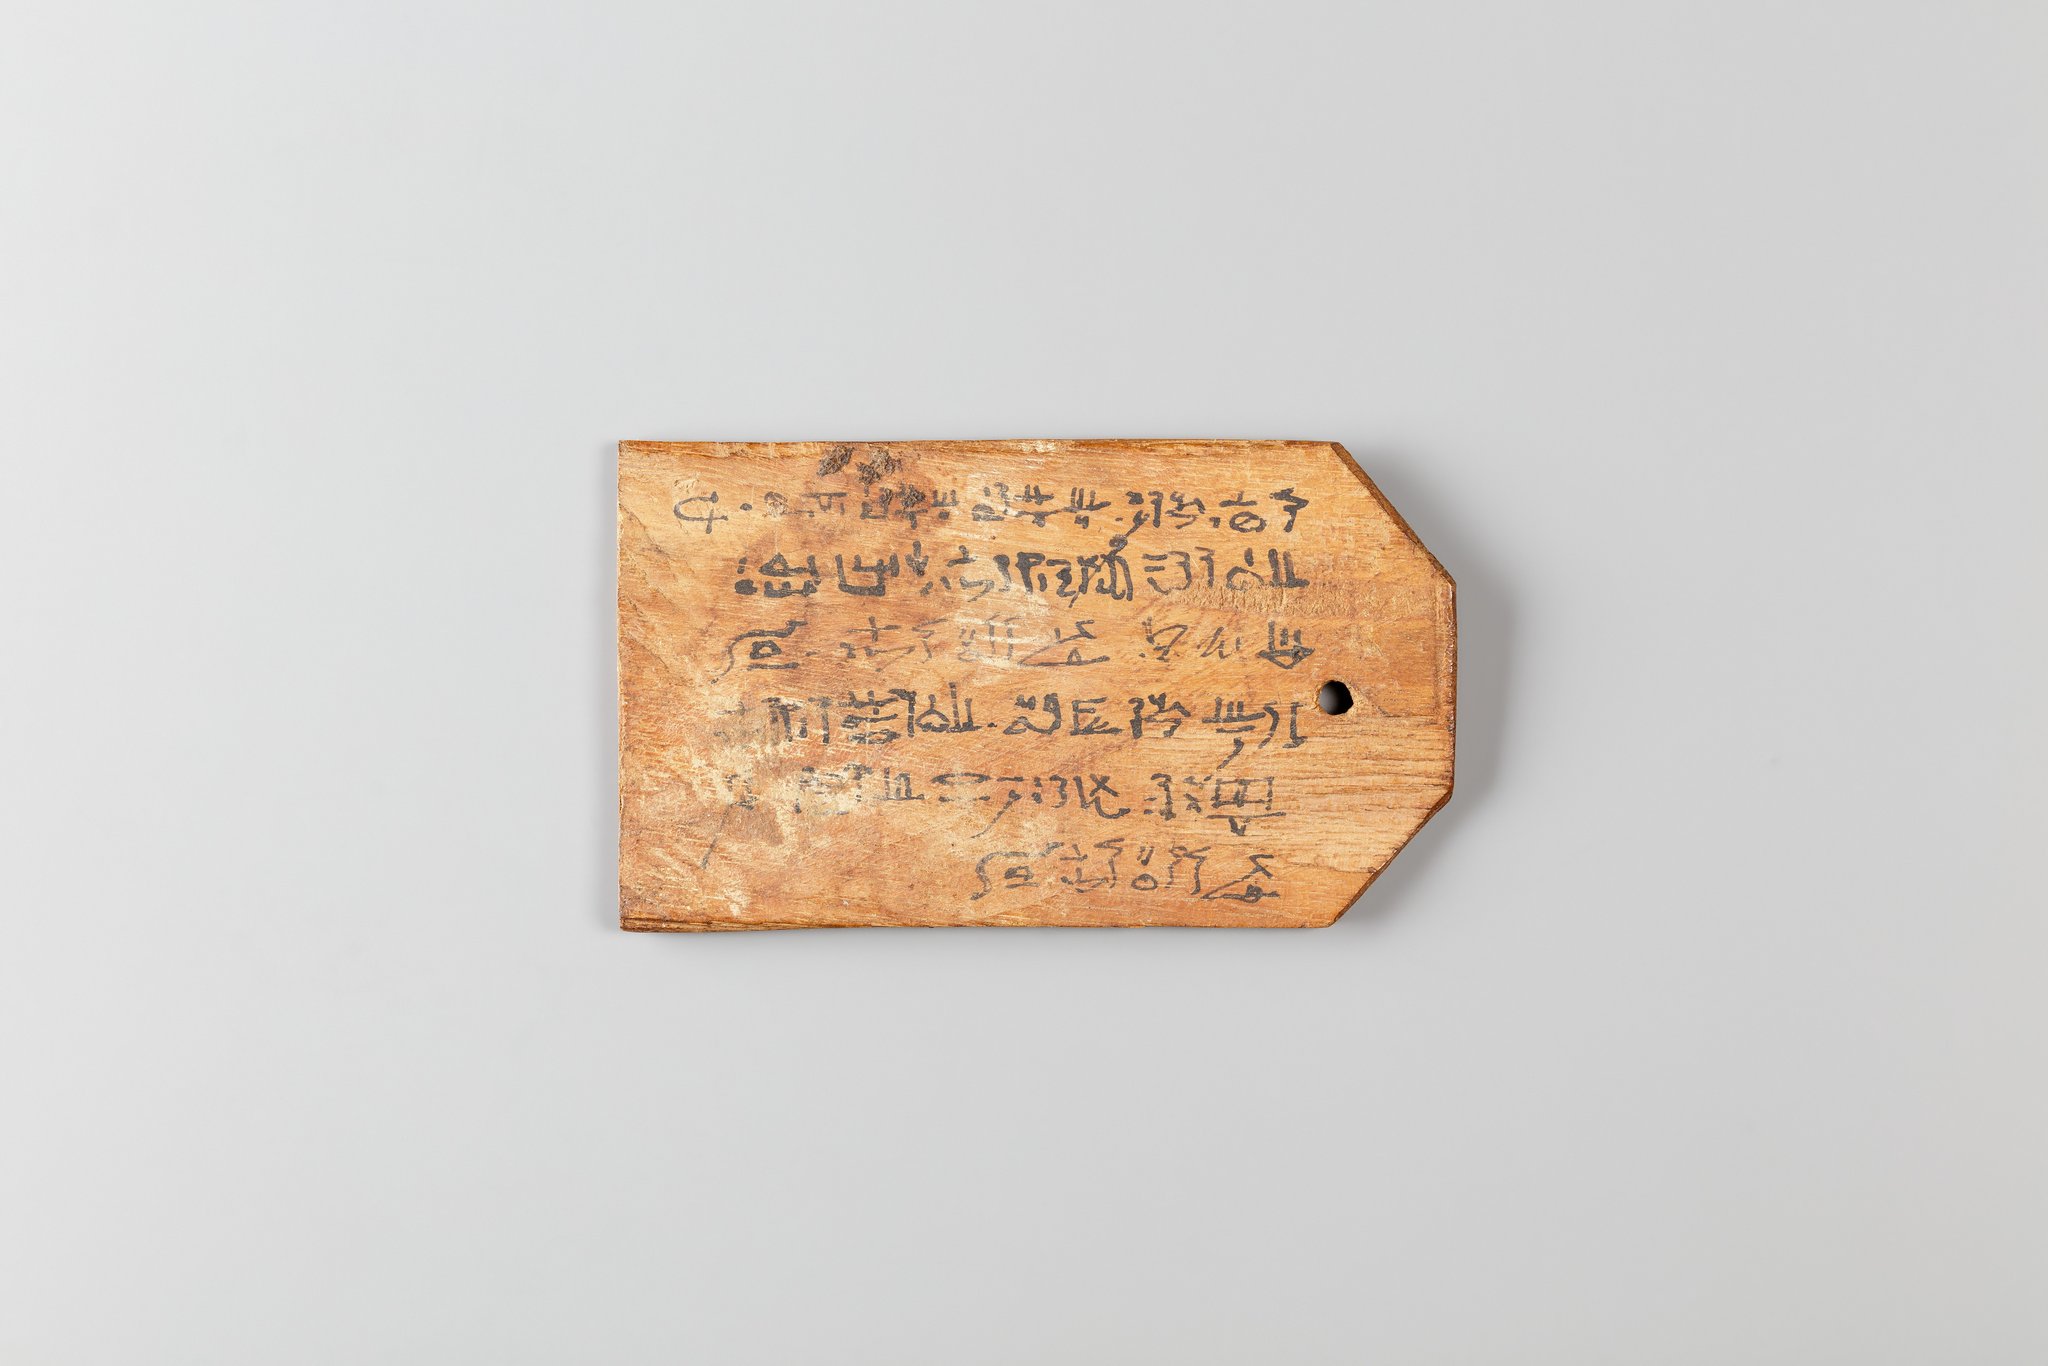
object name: mummy label, petempto the younger, son of petemin, his mother kolluthe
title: Mummy label of Petemin, the son of Petempto, whose father was Petemin the Younger; his mother Thatre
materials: ink, wood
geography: northern upper egypt